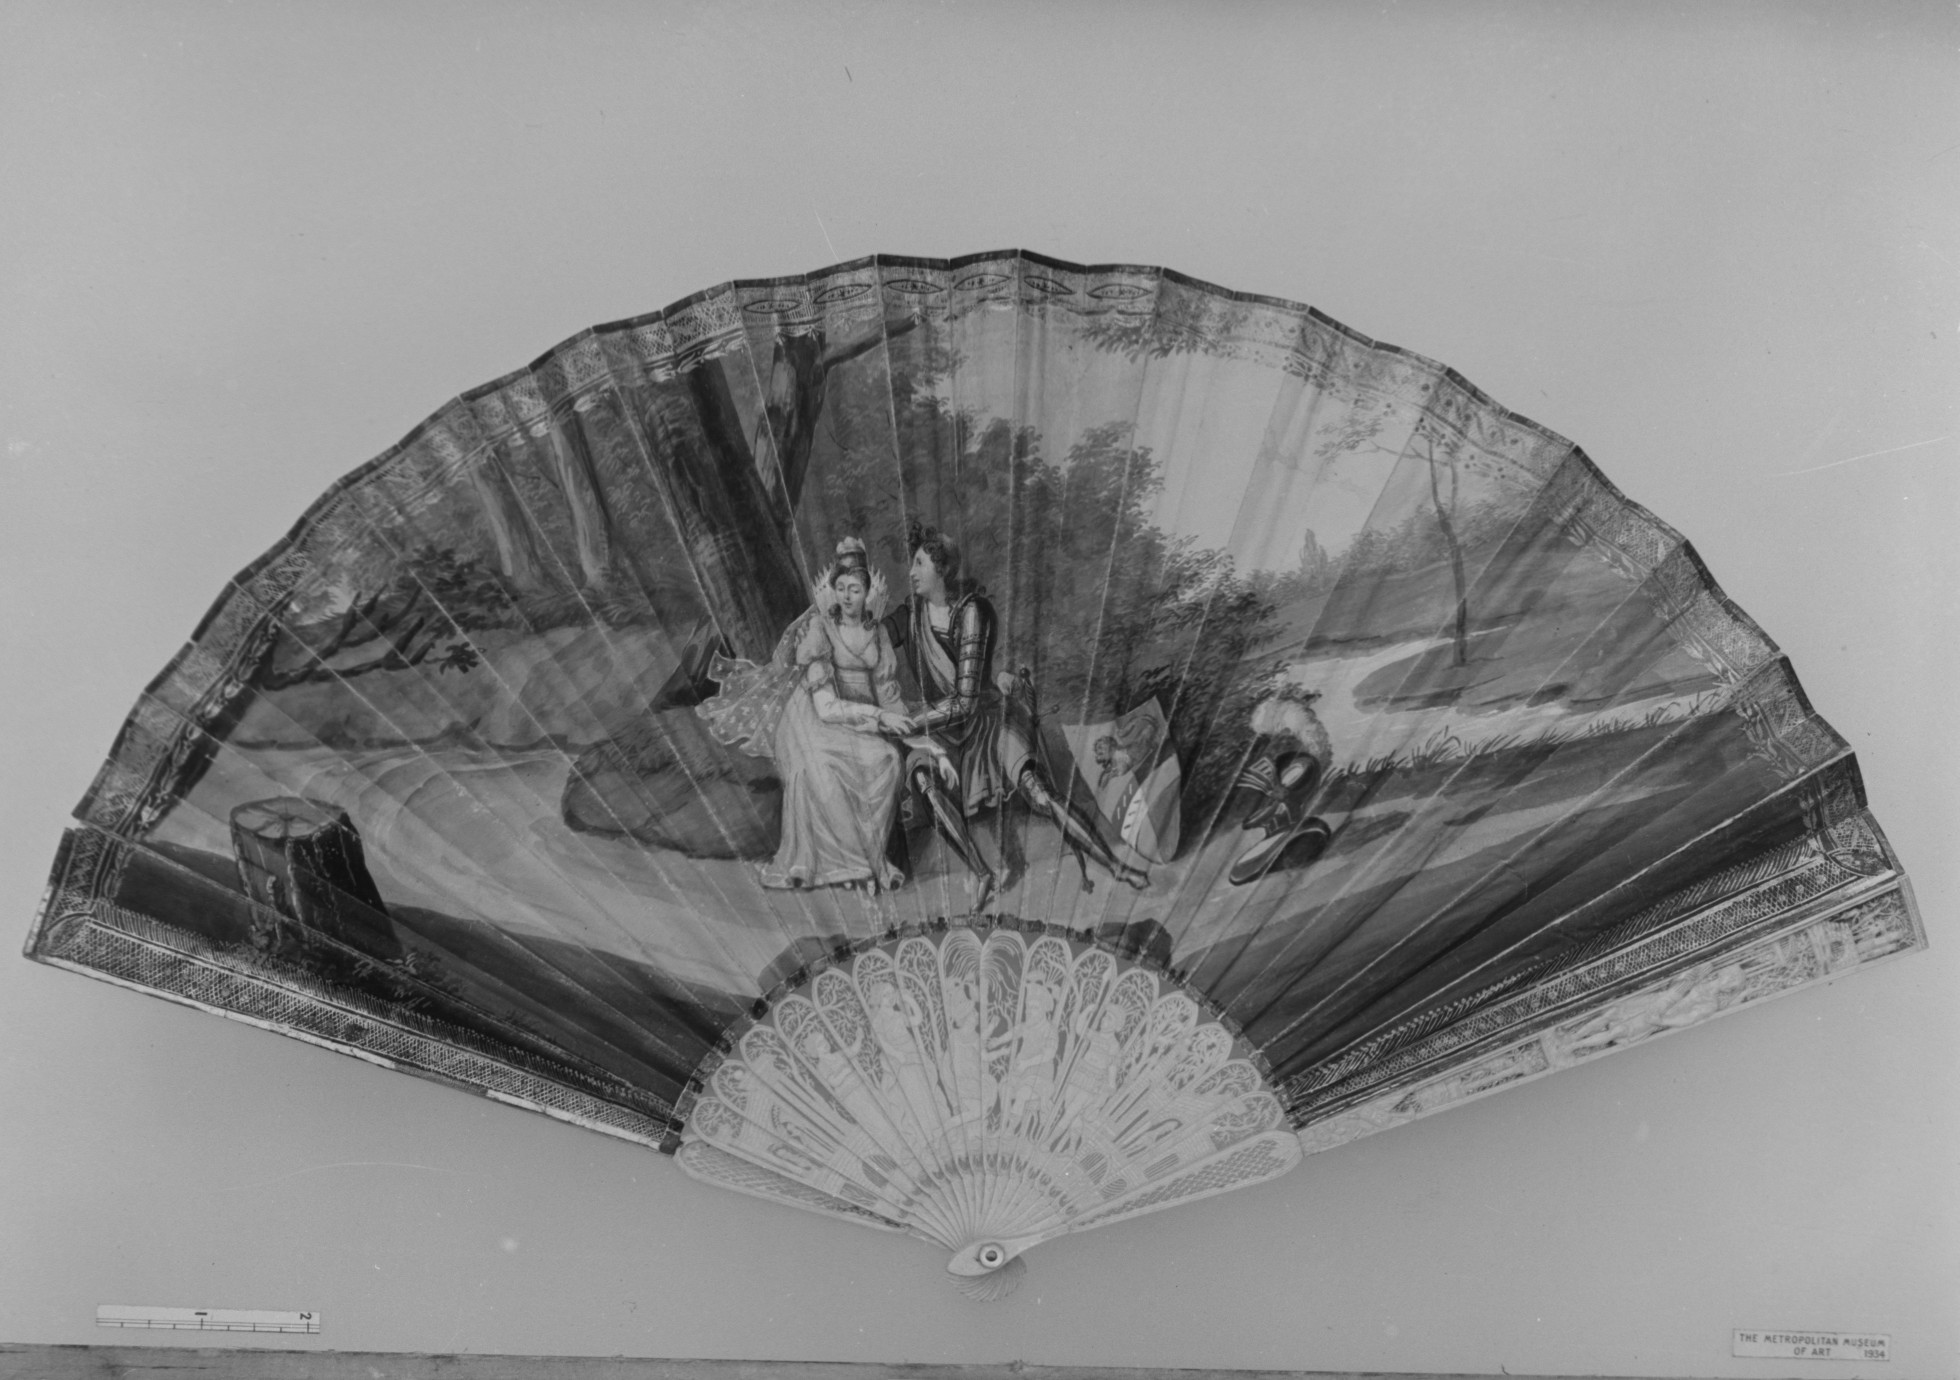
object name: fan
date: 1815-1825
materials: ivory, paper, skin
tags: couples,men,women